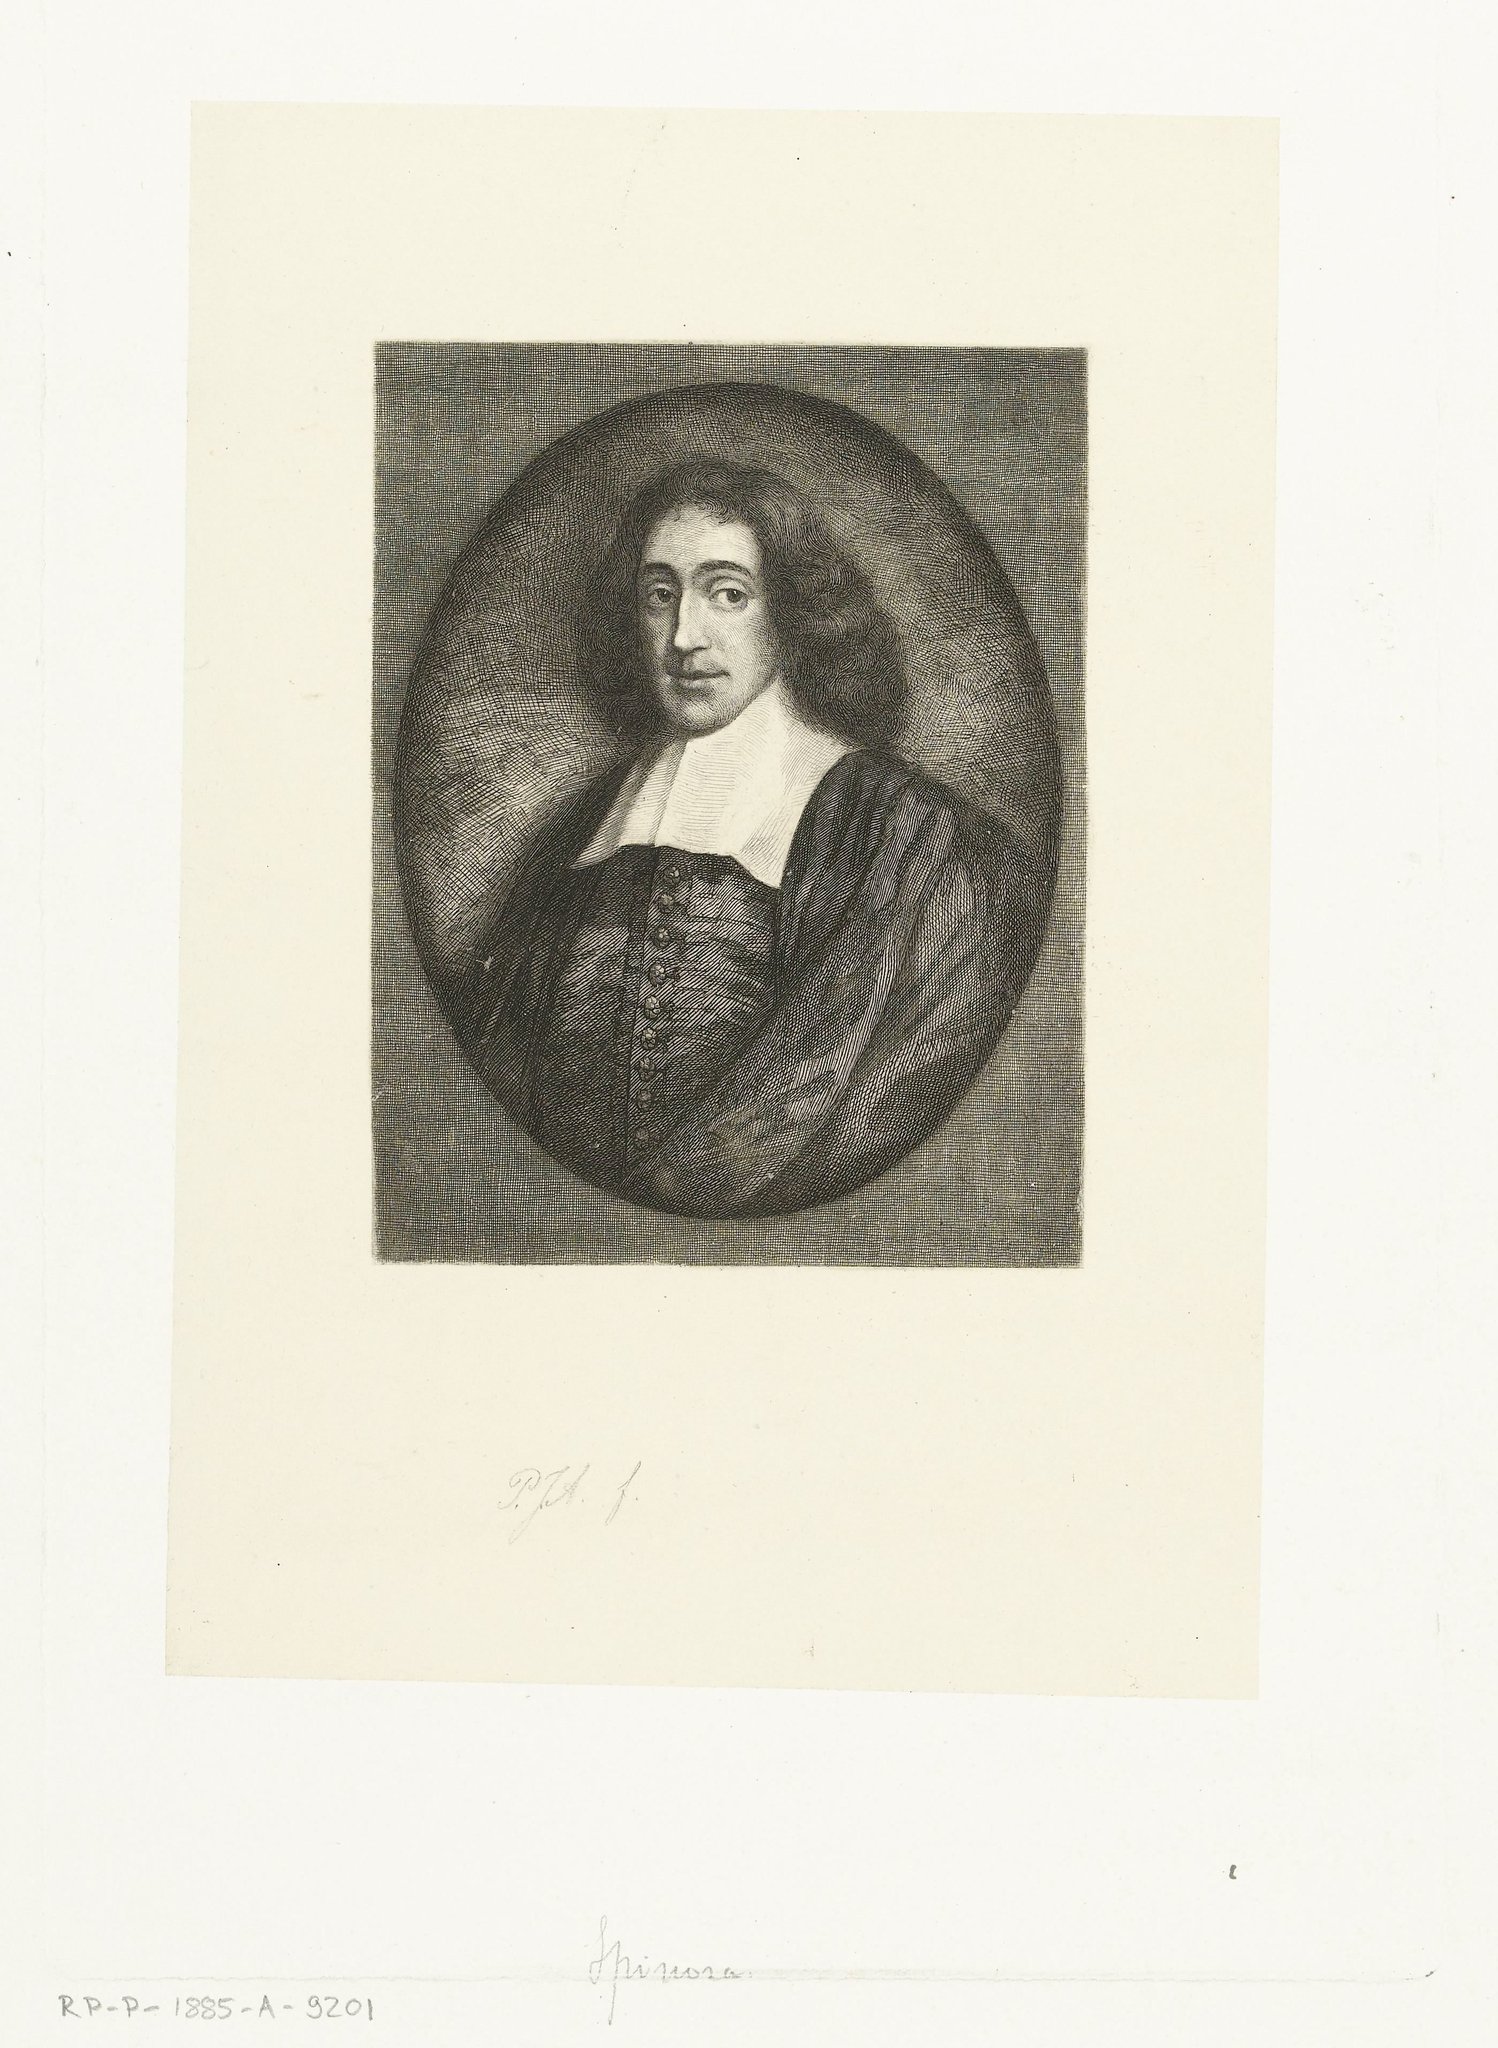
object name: print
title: Portret van Spinoza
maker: petrus johannes arendzen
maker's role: draughtsman, print maker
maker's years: 1846-1932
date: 1856-1885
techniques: printmaking, etching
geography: netherlands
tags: amsterdam, the hague, baruch de spinoza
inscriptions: collector's mark: Lugt 2228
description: Naar een schilderij in het Museum te Kassel?. ook gebruikt als boekillustratie: Spinoza, Opera quotquot reperta sunt, 1882.